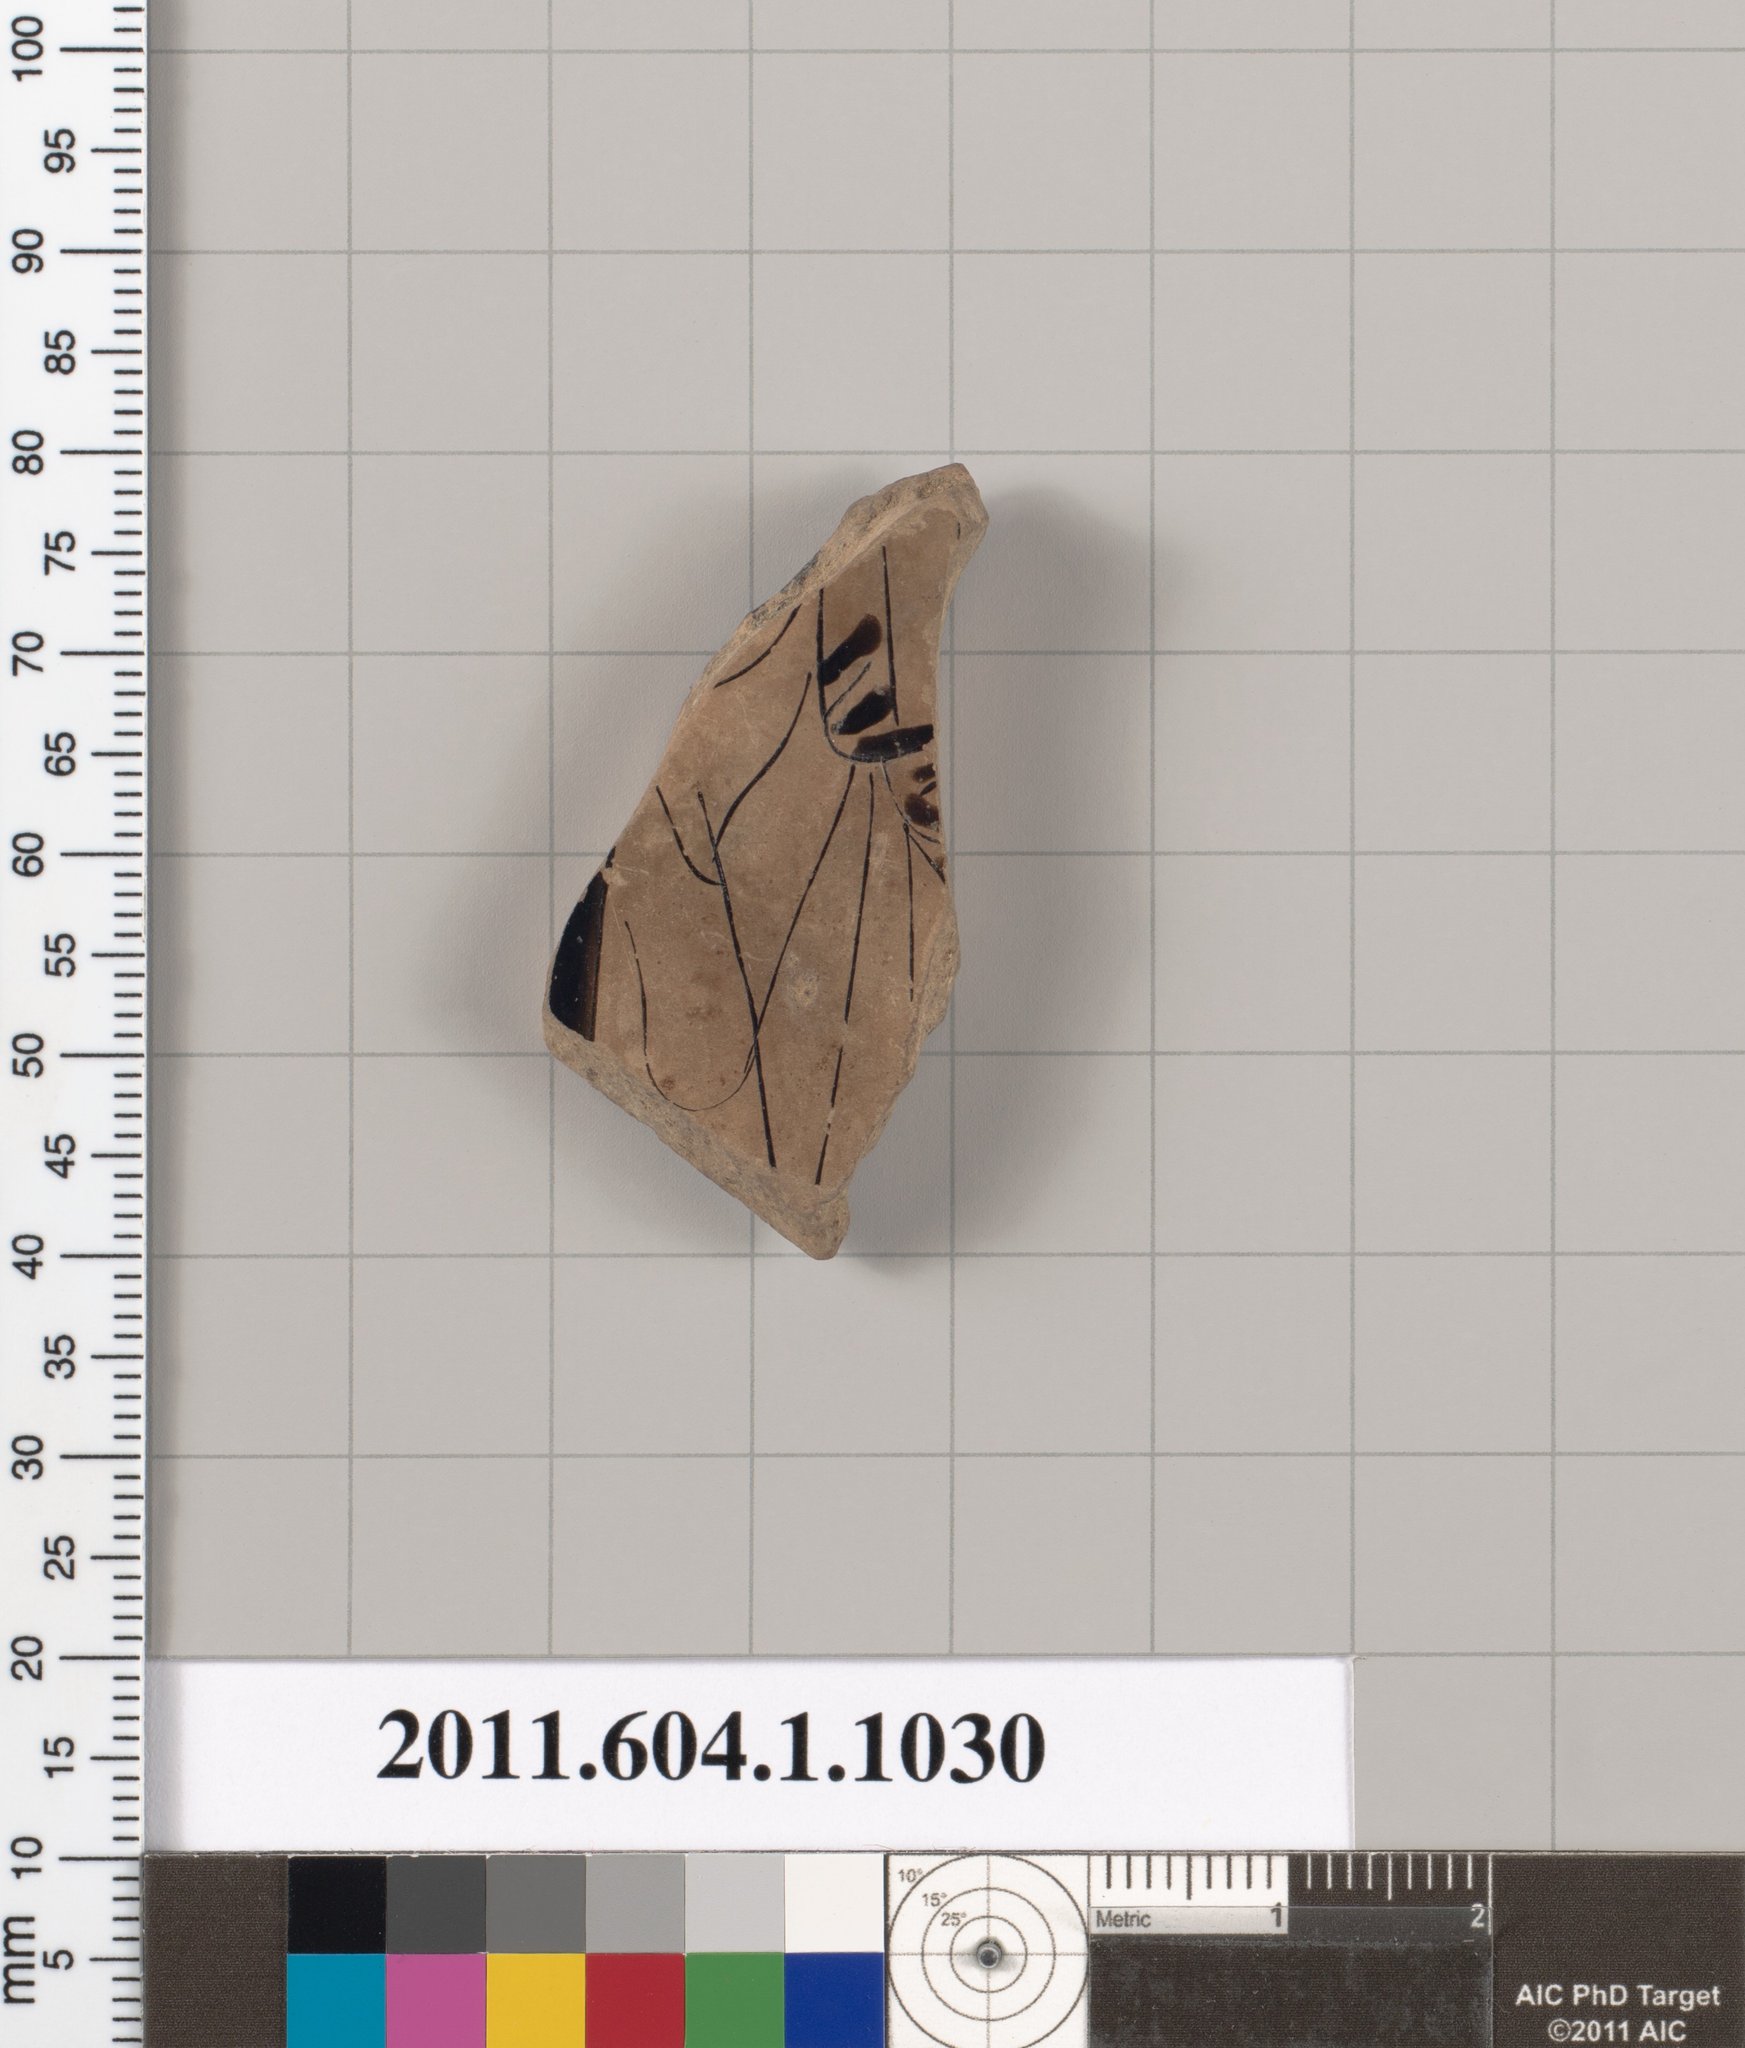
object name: kylix fragment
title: Terracotta fragment of a kylix (drinking cup)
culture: greek, attic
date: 475-451 BCE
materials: terracotta